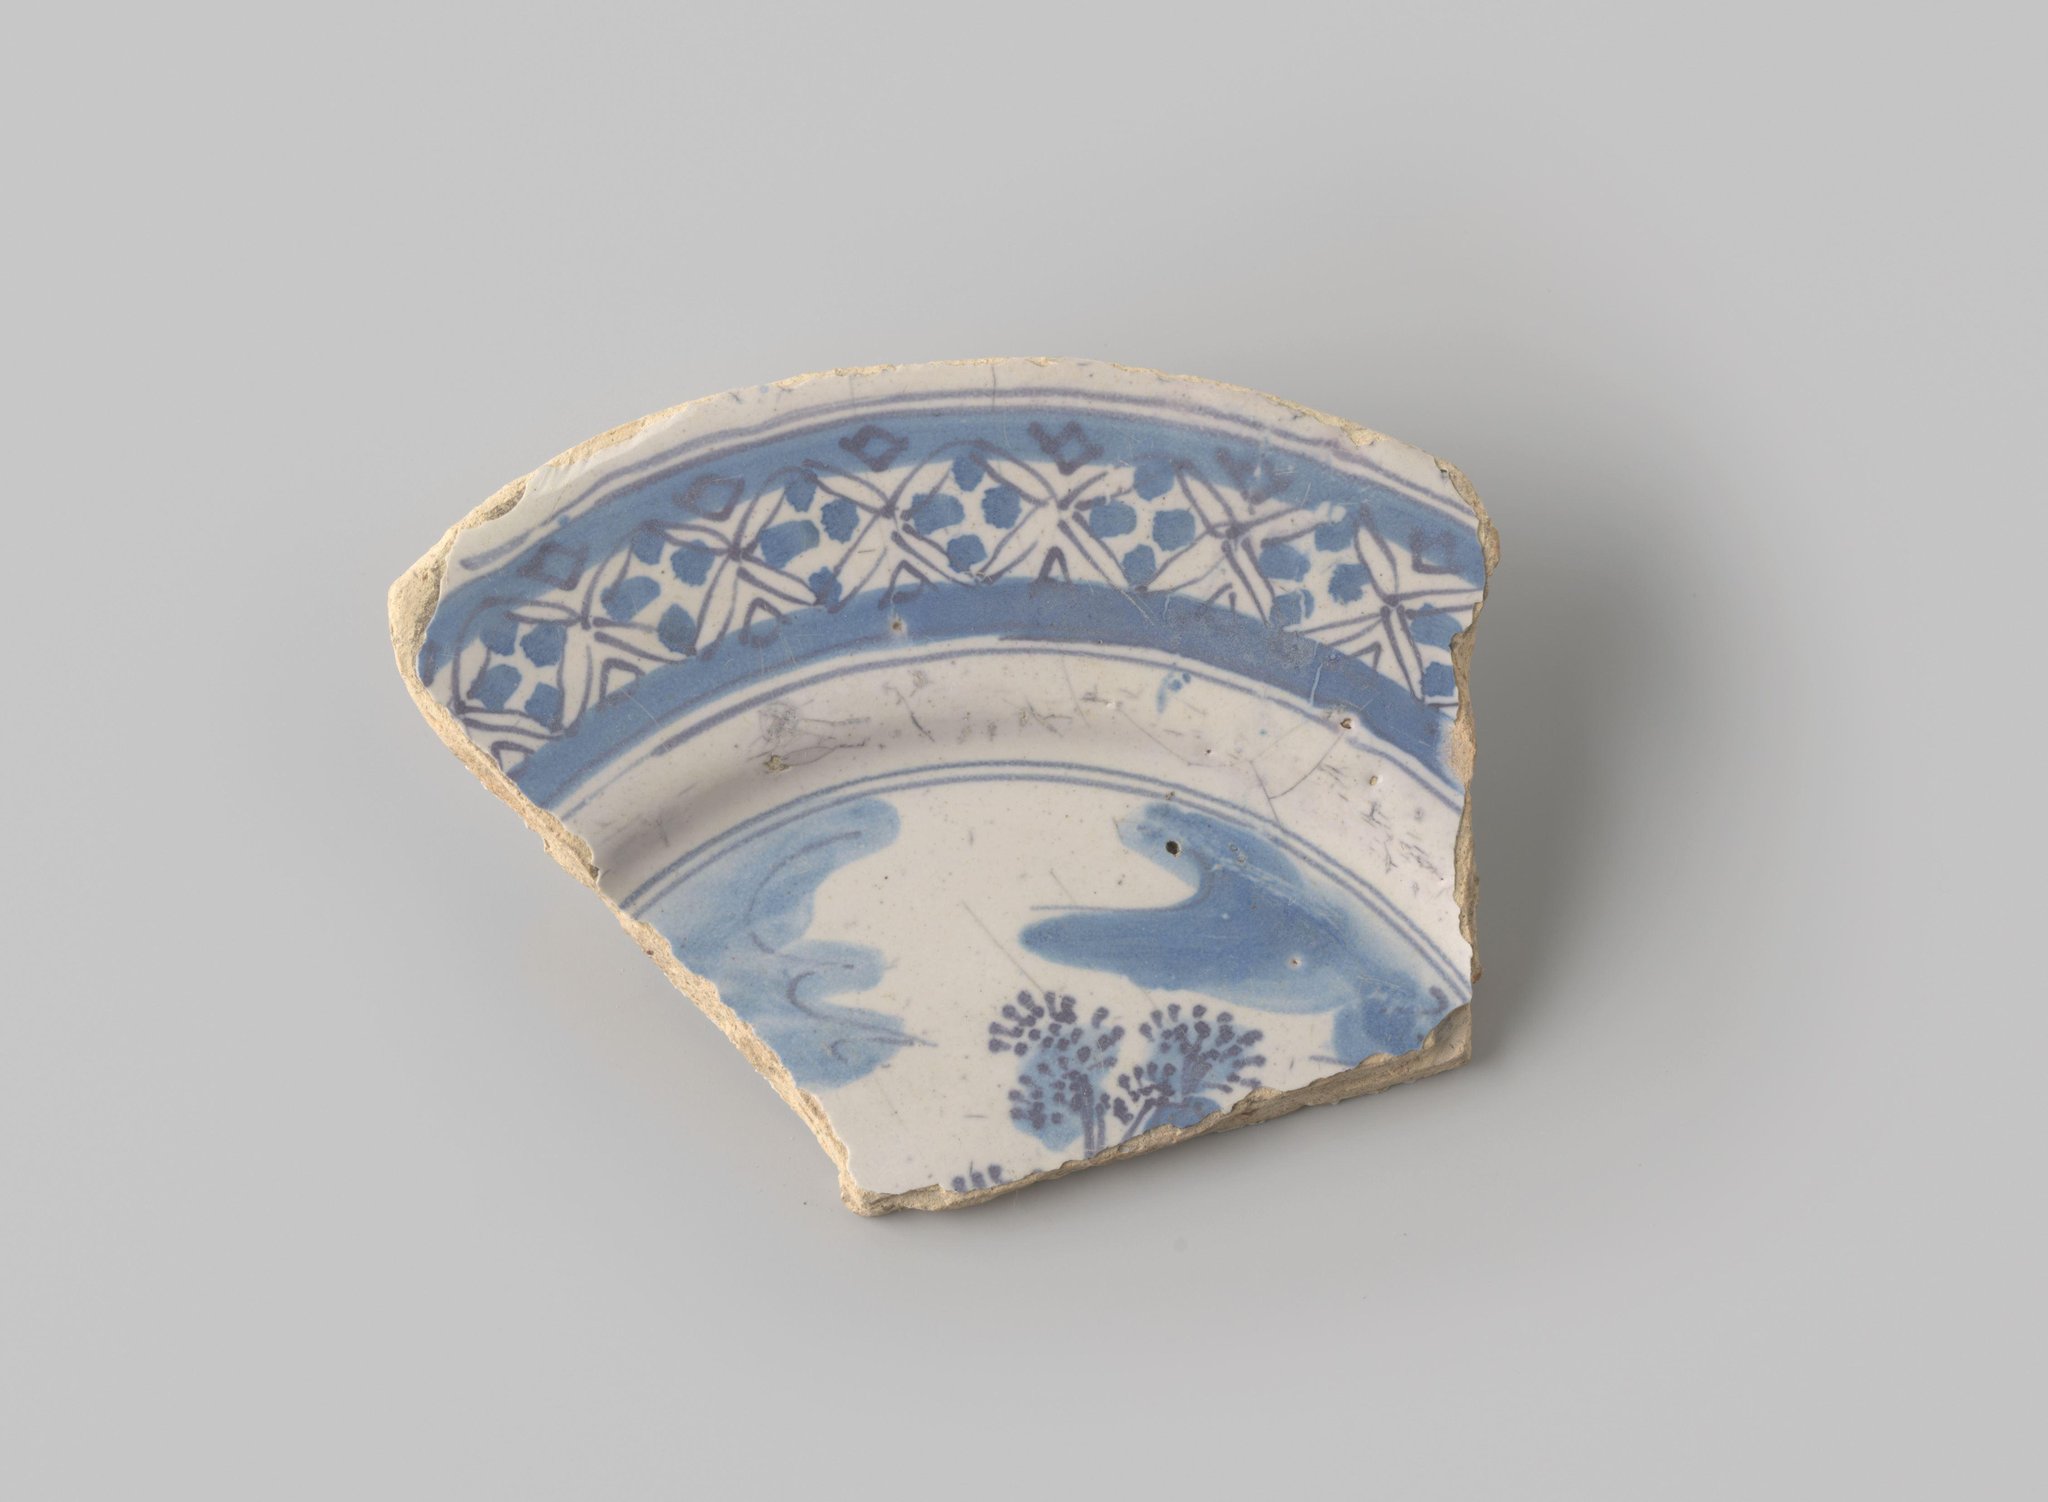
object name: fragment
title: Scherf van gelig bakkend aardewerk, voorzien van wit glazuur, aan de voorzijde voorzien van een schildering van een lucht met boom en een sierrand in blauw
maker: Anonymous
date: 1600-1650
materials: earthenware, glaze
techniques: maiolica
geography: northern netherlands